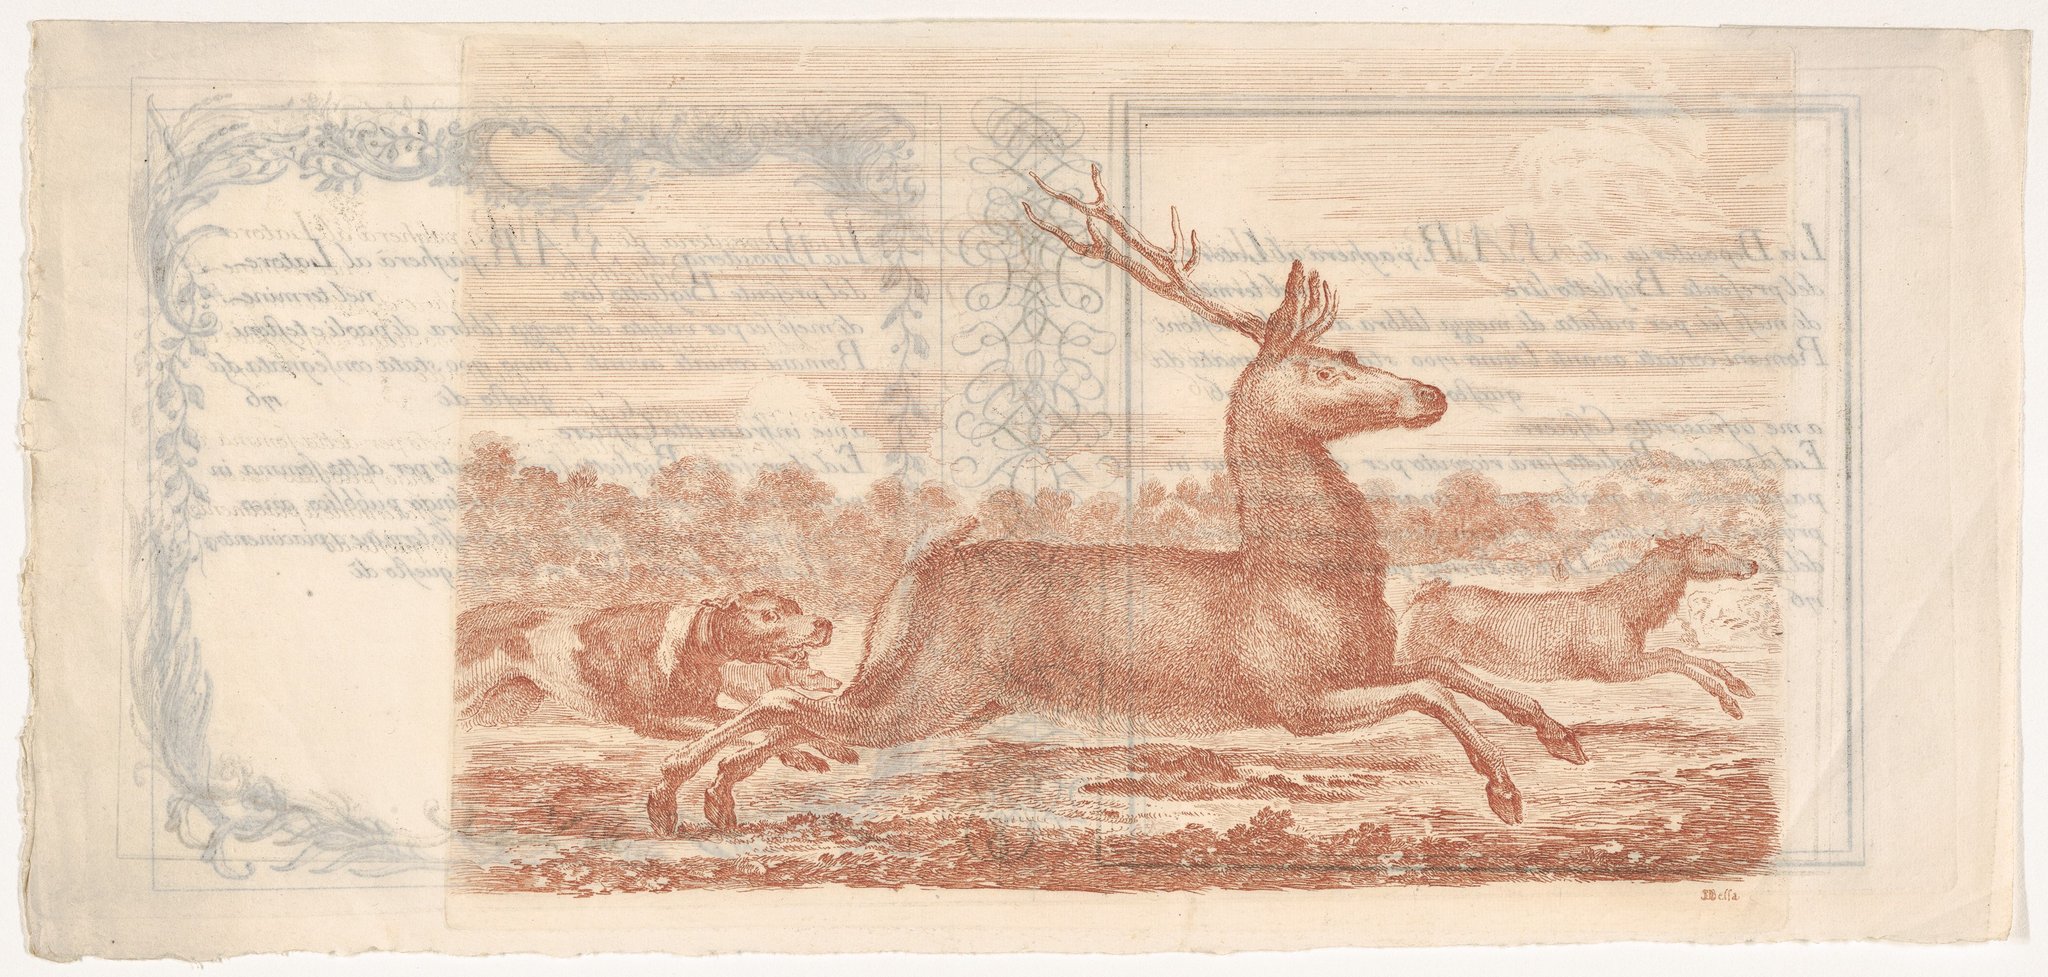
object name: print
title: Stag and doe running towards the right, two dogs behind them to left, from "Hunts of various animals" (Chasses à différents animaux)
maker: stefano della bella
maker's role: artist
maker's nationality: italian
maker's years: 1610-1664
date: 1651-1657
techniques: etching, printing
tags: deer,dogs